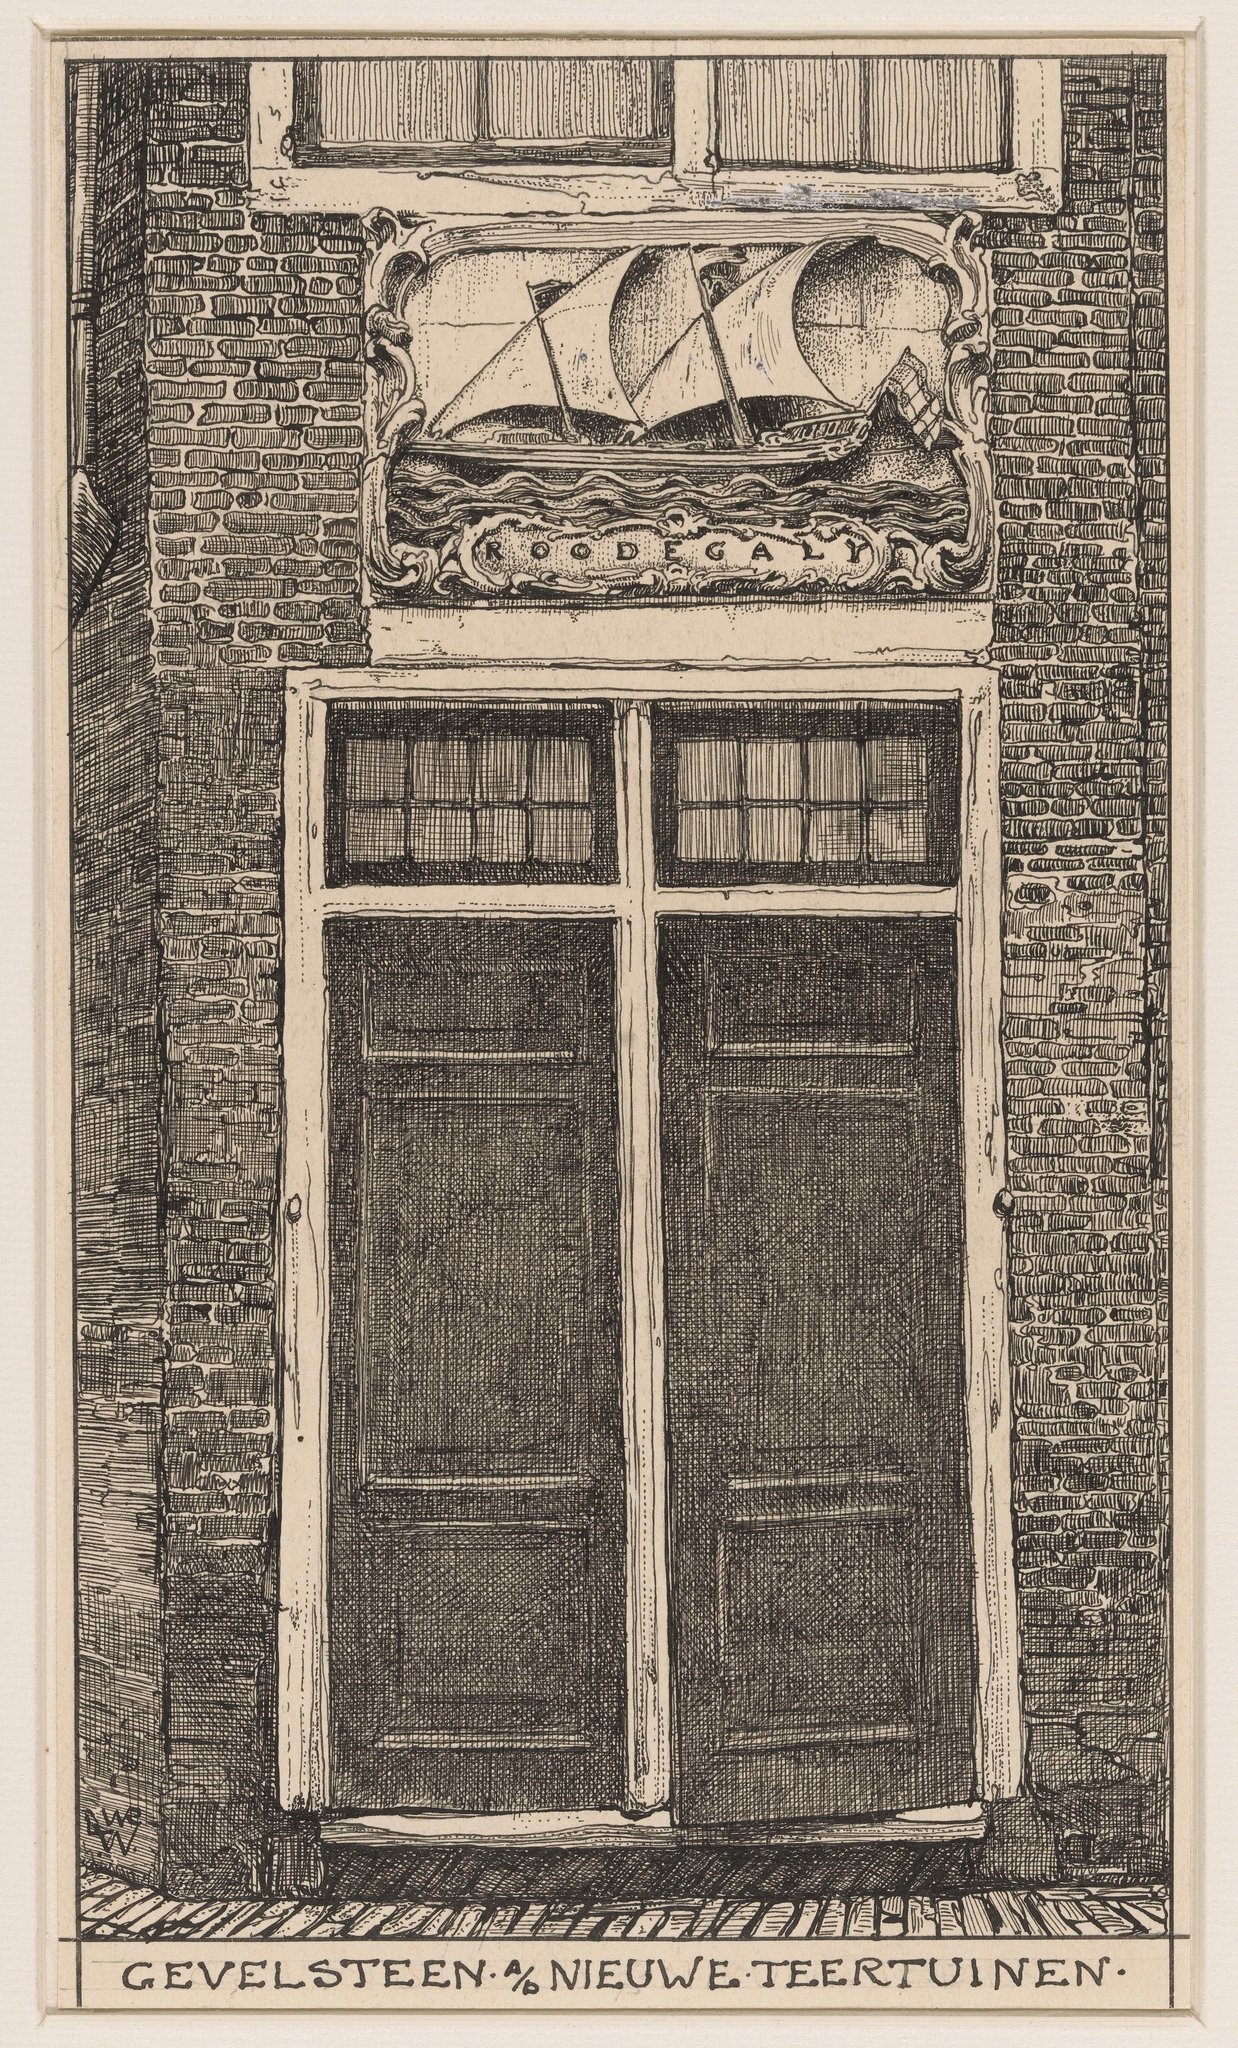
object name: drawing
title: Gevelsteen aan de Nieuwe Teertuinen te Amsterdam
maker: willem wenckebach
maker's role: designer, draughtsman, painter, print maker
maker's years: 1860-1937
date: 1870-1926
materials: paint, ink, paper, pencil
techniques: pen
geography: amsterdam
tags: stone tablet in façade, amsterdam